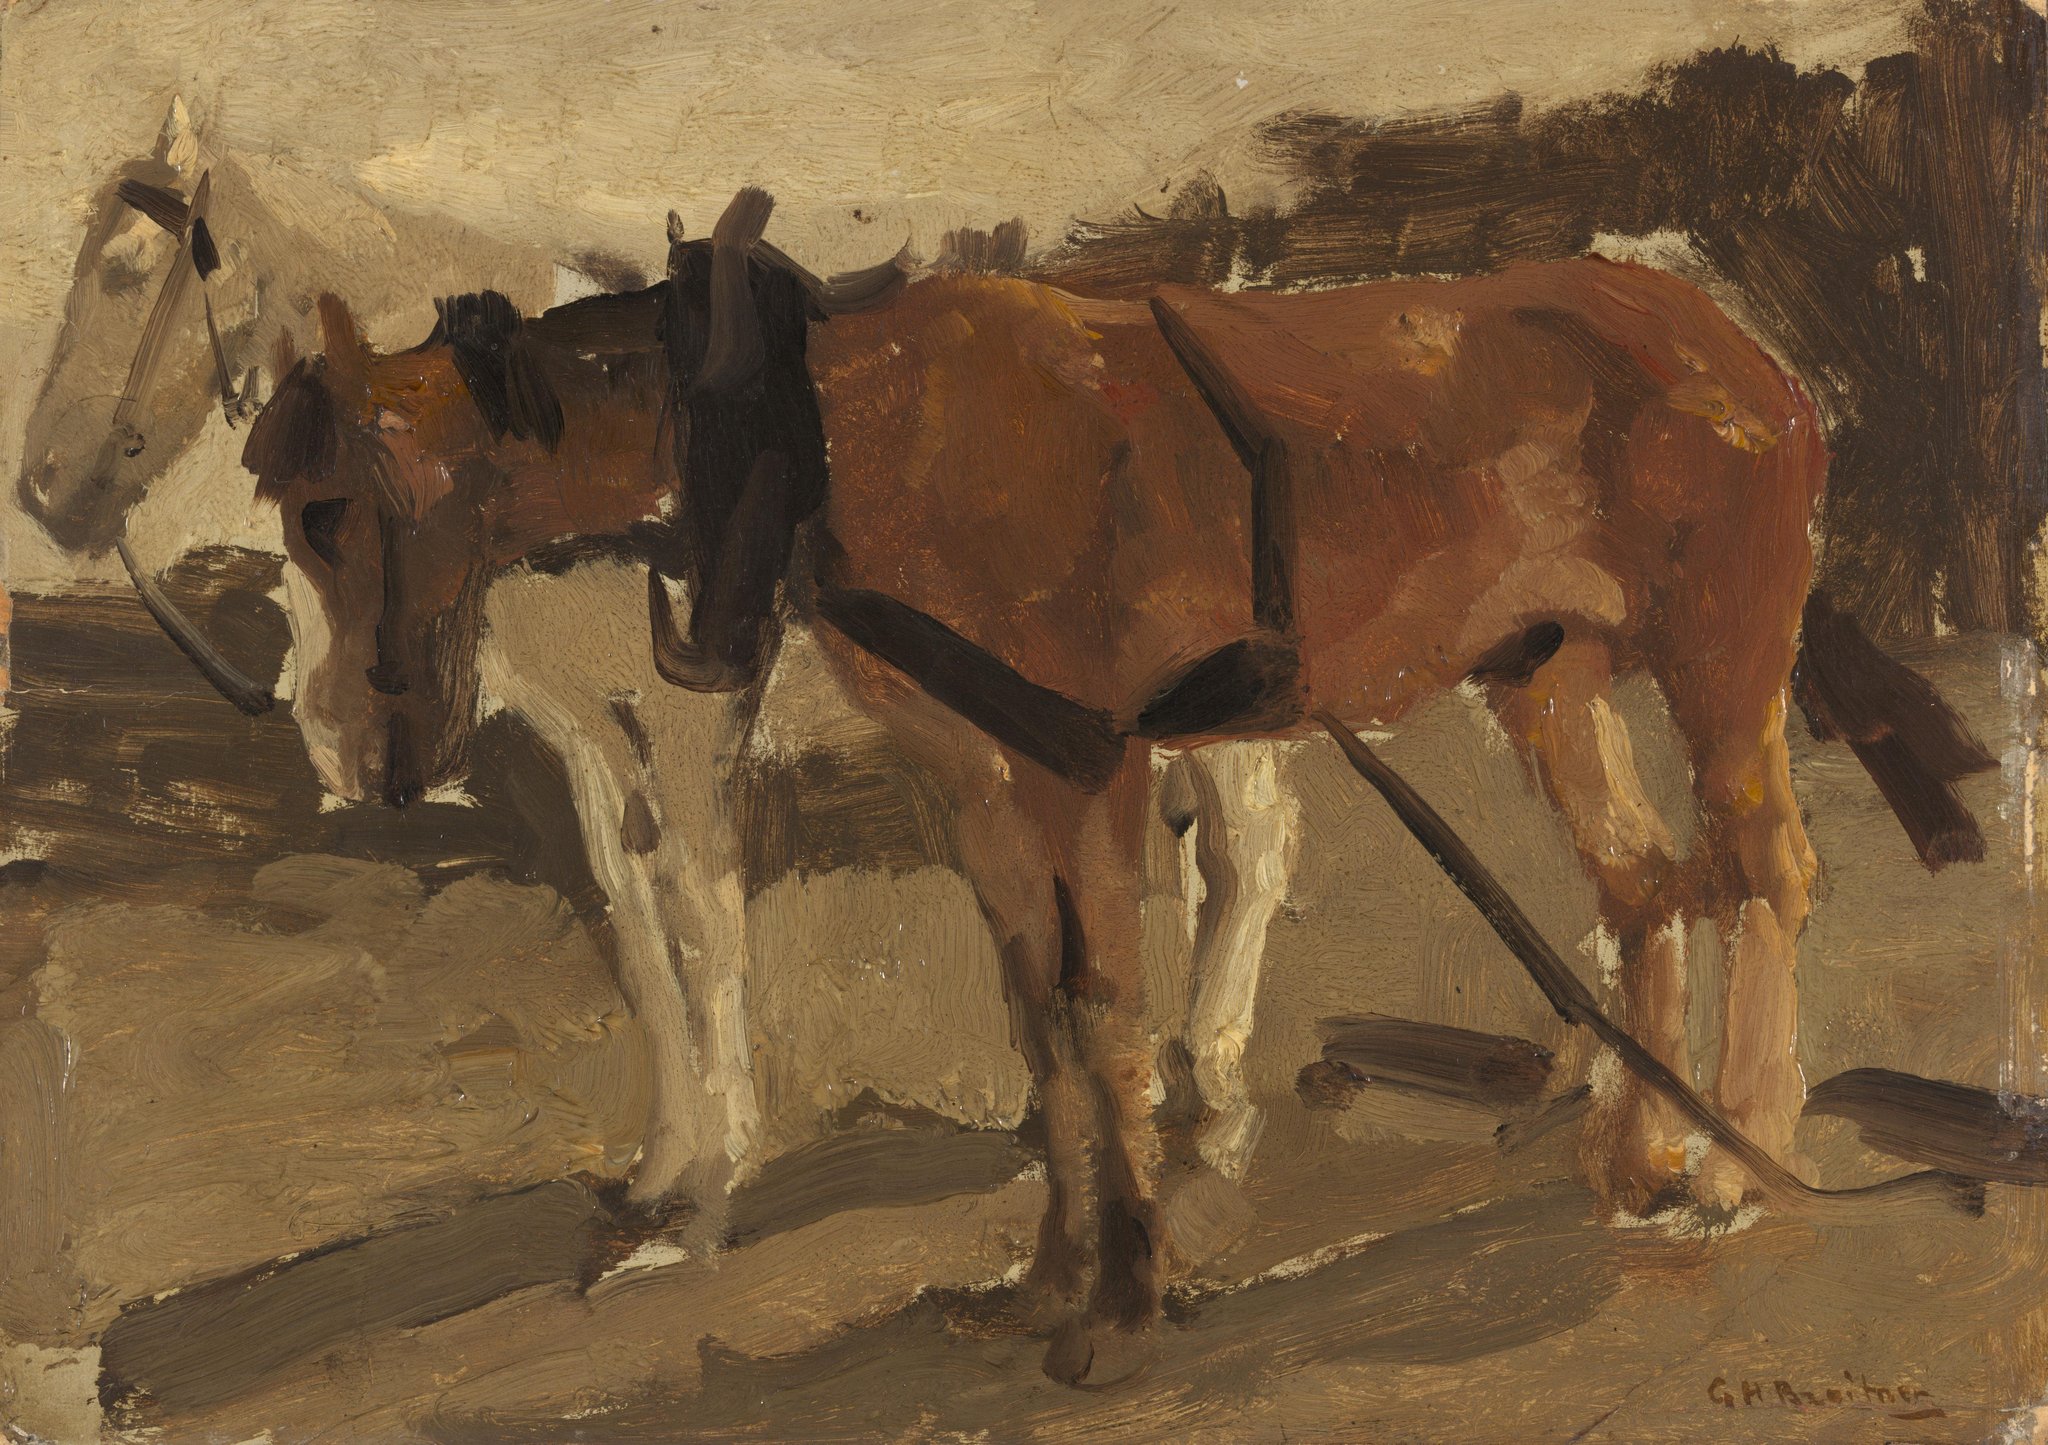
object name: painting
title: A Brown and a White Horse in Scheveningen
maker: george hendrik breitner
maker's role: draughtsman, painter, print maker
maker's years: 1857-1923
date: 1880-1923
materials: oil, panel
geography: netherlands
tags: horse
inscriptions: signature: ‘G.H. Breitner’